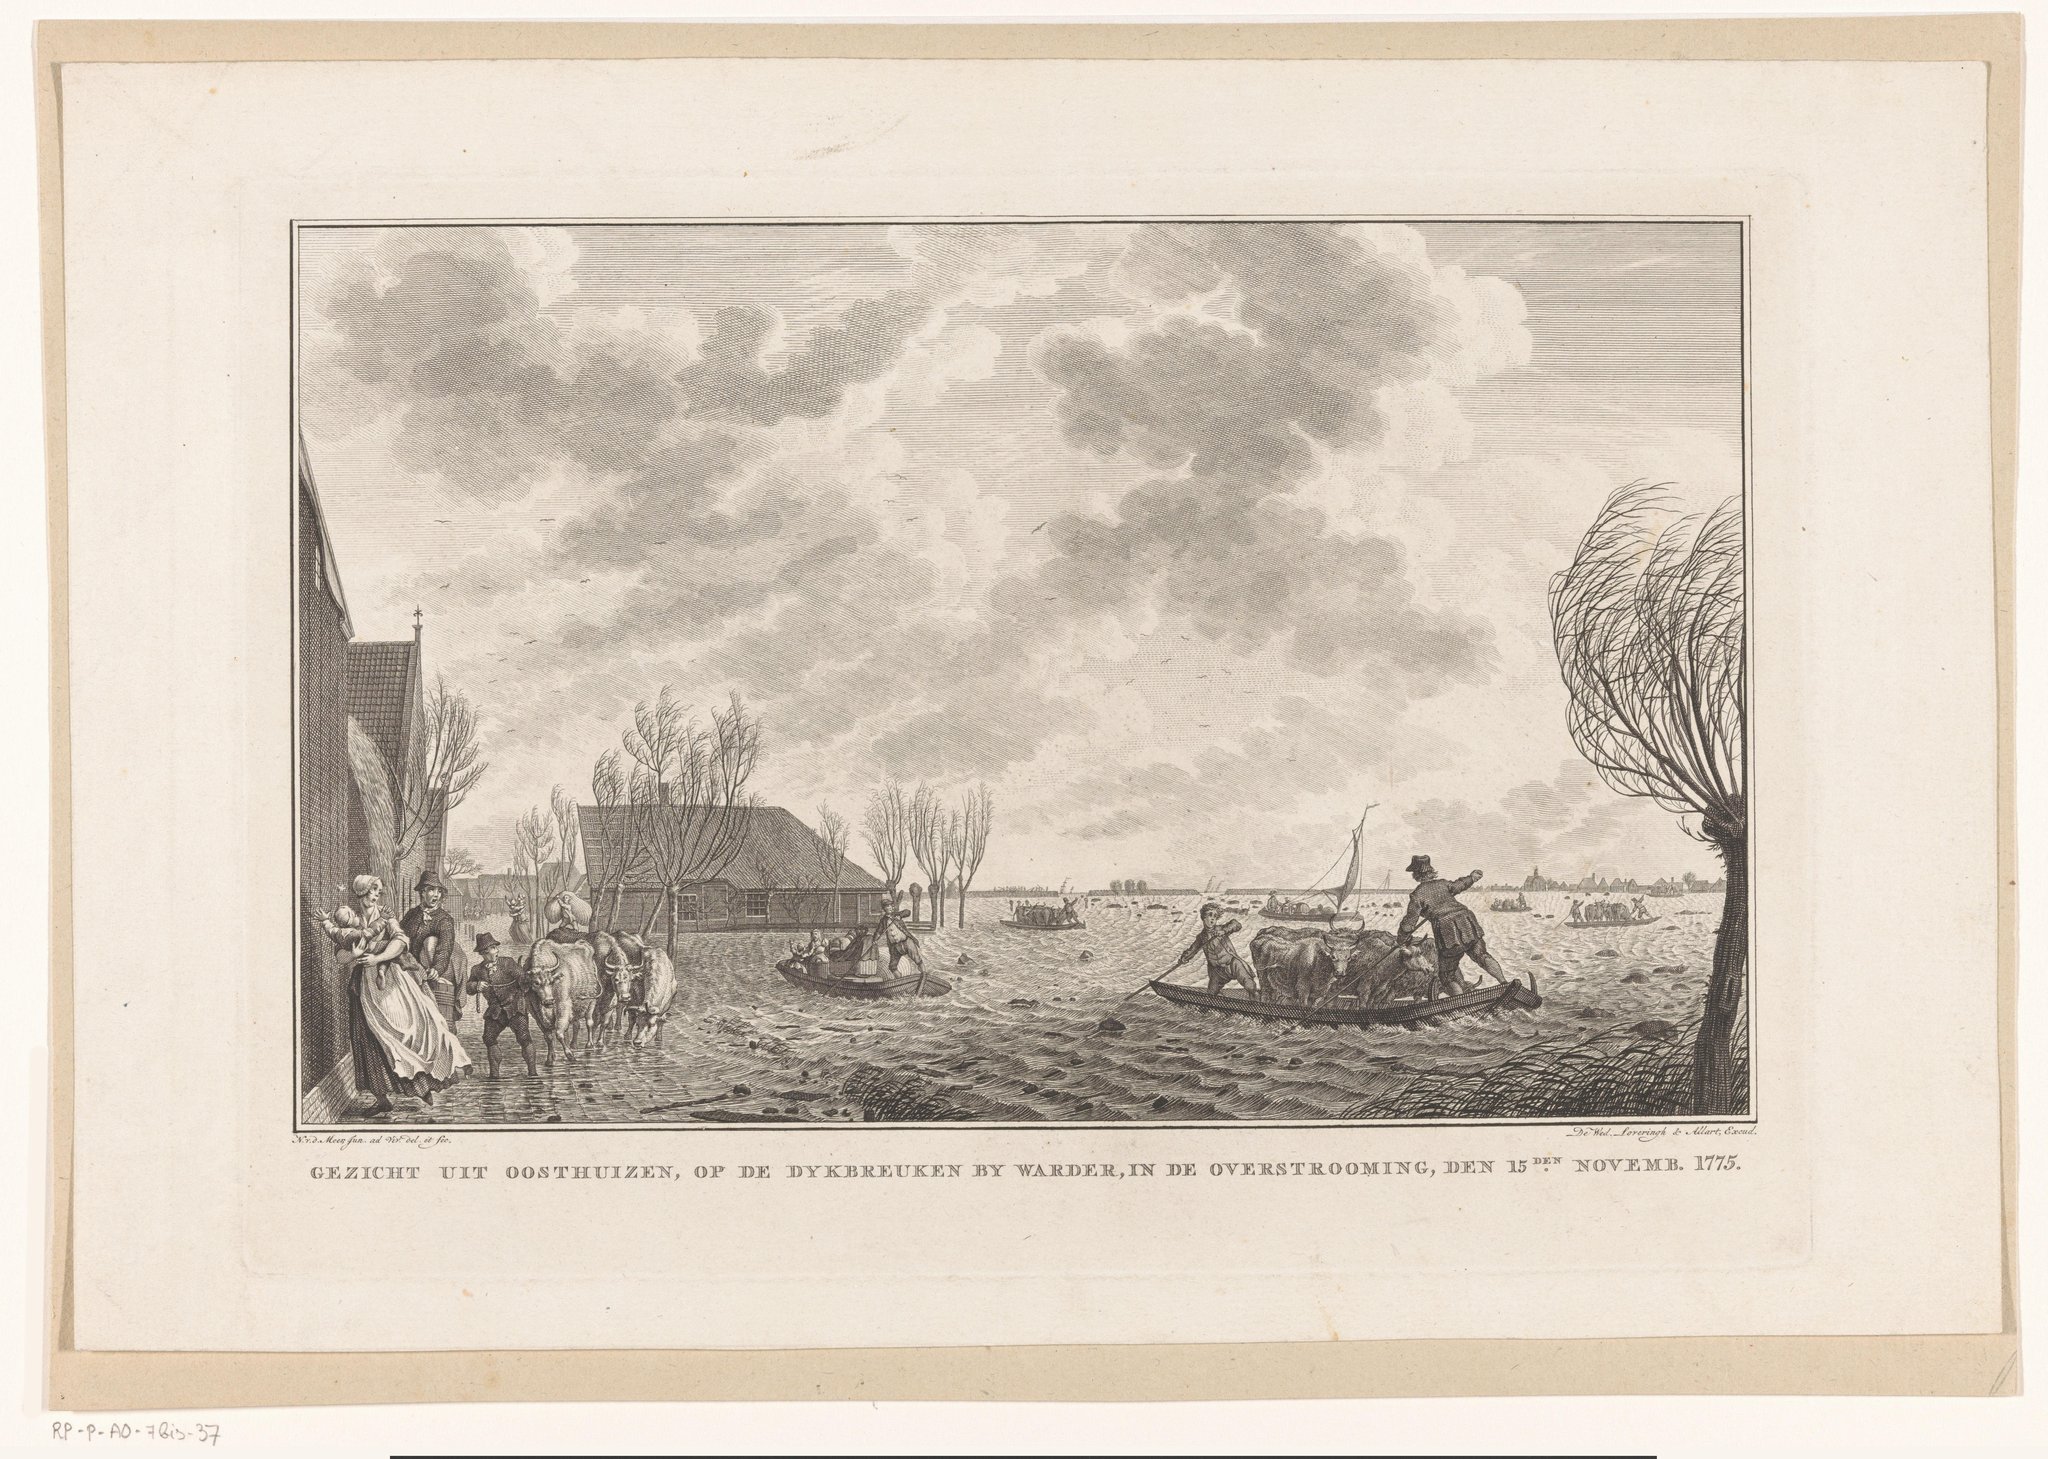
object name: print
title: Watersnood te Oosthuizen na dijkbreuk bij Warder, 1775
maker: noach van der meer (ii)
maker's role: draughtsman, print maker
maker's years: 1741-1822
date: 1775-1776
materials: paper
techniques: engraving, etching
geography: netherlands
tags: rescue work during a flood, dike-break, the flood of 14-18 november 1775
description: Het dorp Oosthuizen getroffen door overstromingen na de dijkdoorbraak bij Warder op 15 november 1775. Bewoners proberen in schuiten huisraad en dieren te redden. Onderdeel van een groep illustraties van de overstromingen in 1775.